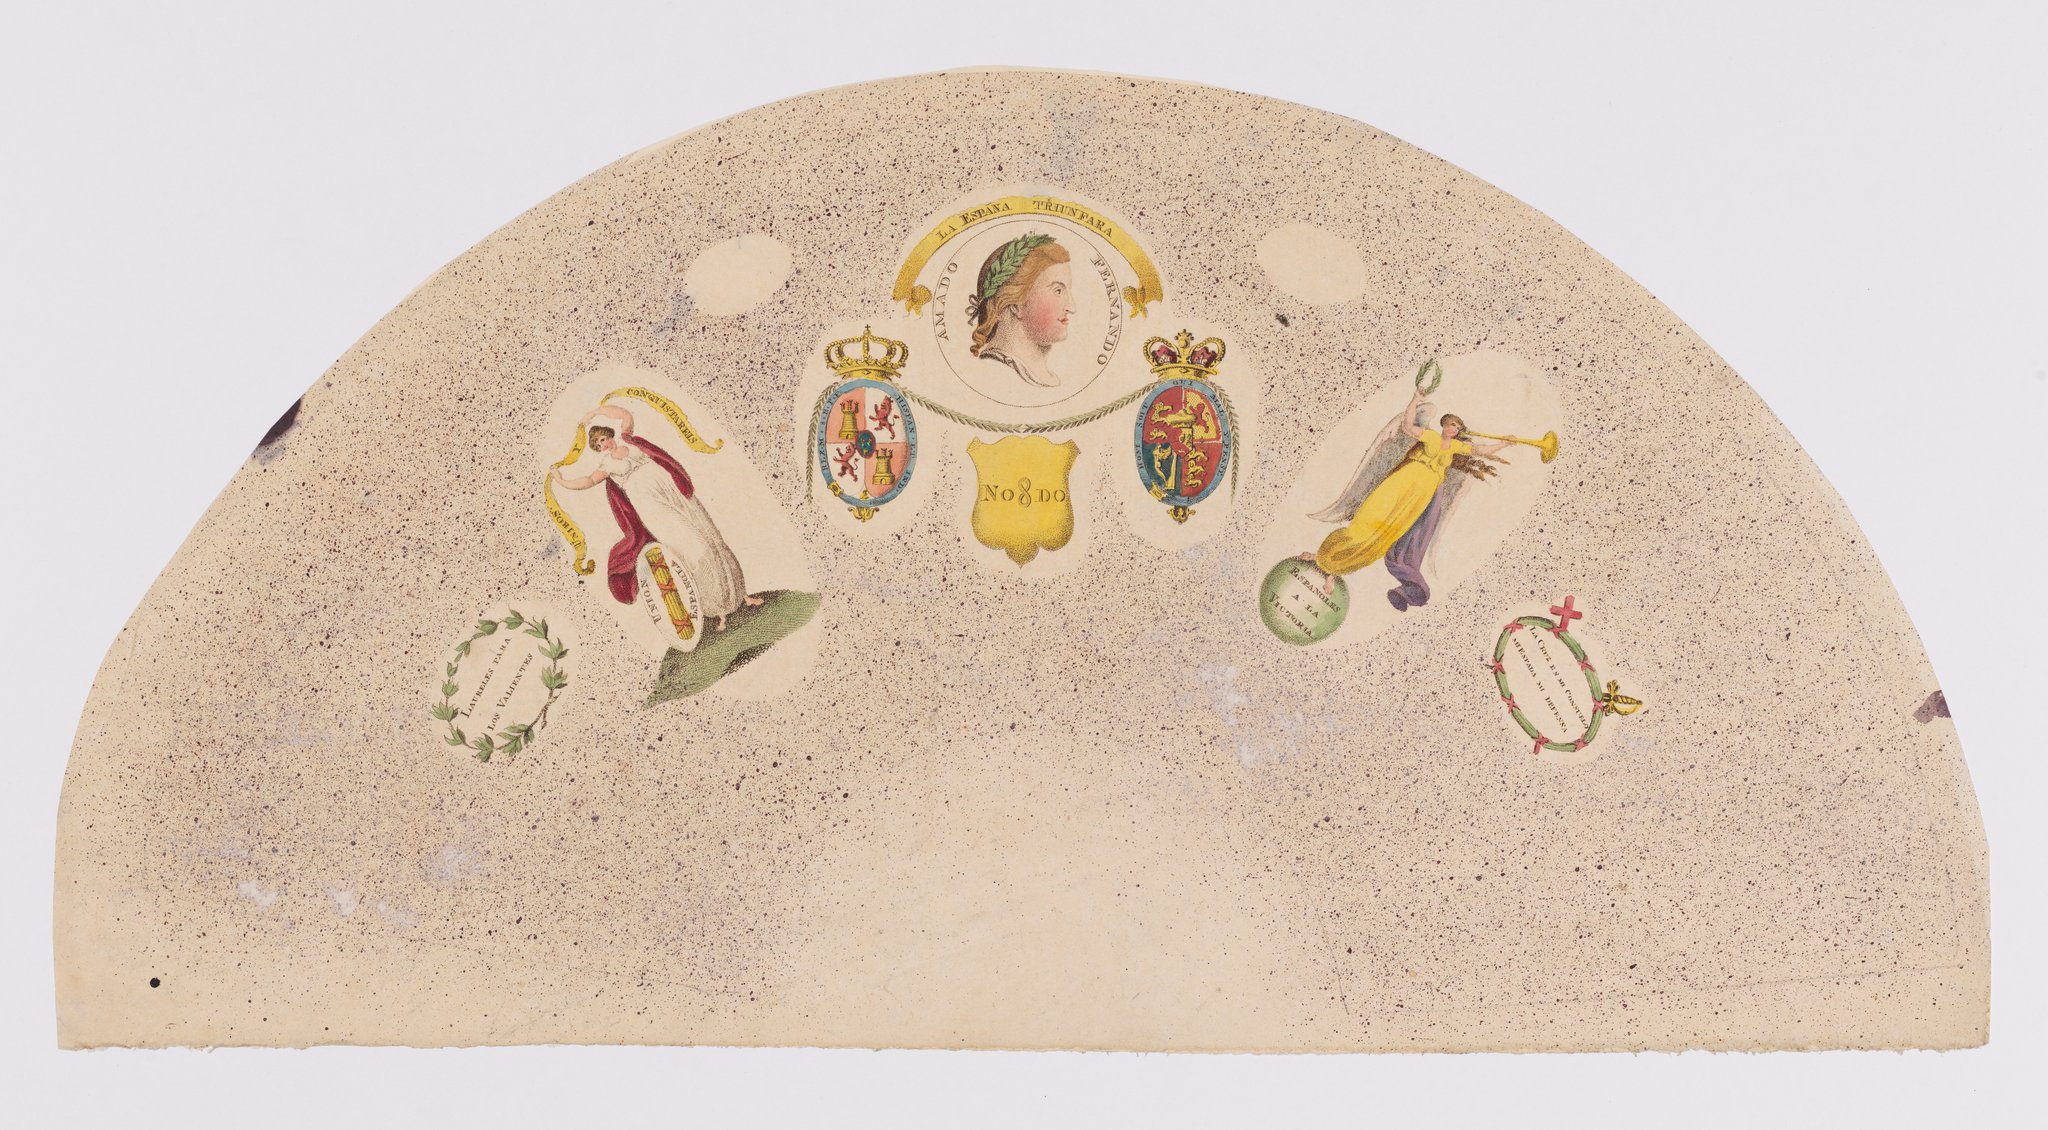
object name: print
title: La España Triunfara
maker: anonymous, british, 19th century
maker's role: artist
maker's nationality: british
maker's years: 1800-1900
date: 1814-1815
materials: ink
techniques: hand coloring, engraving